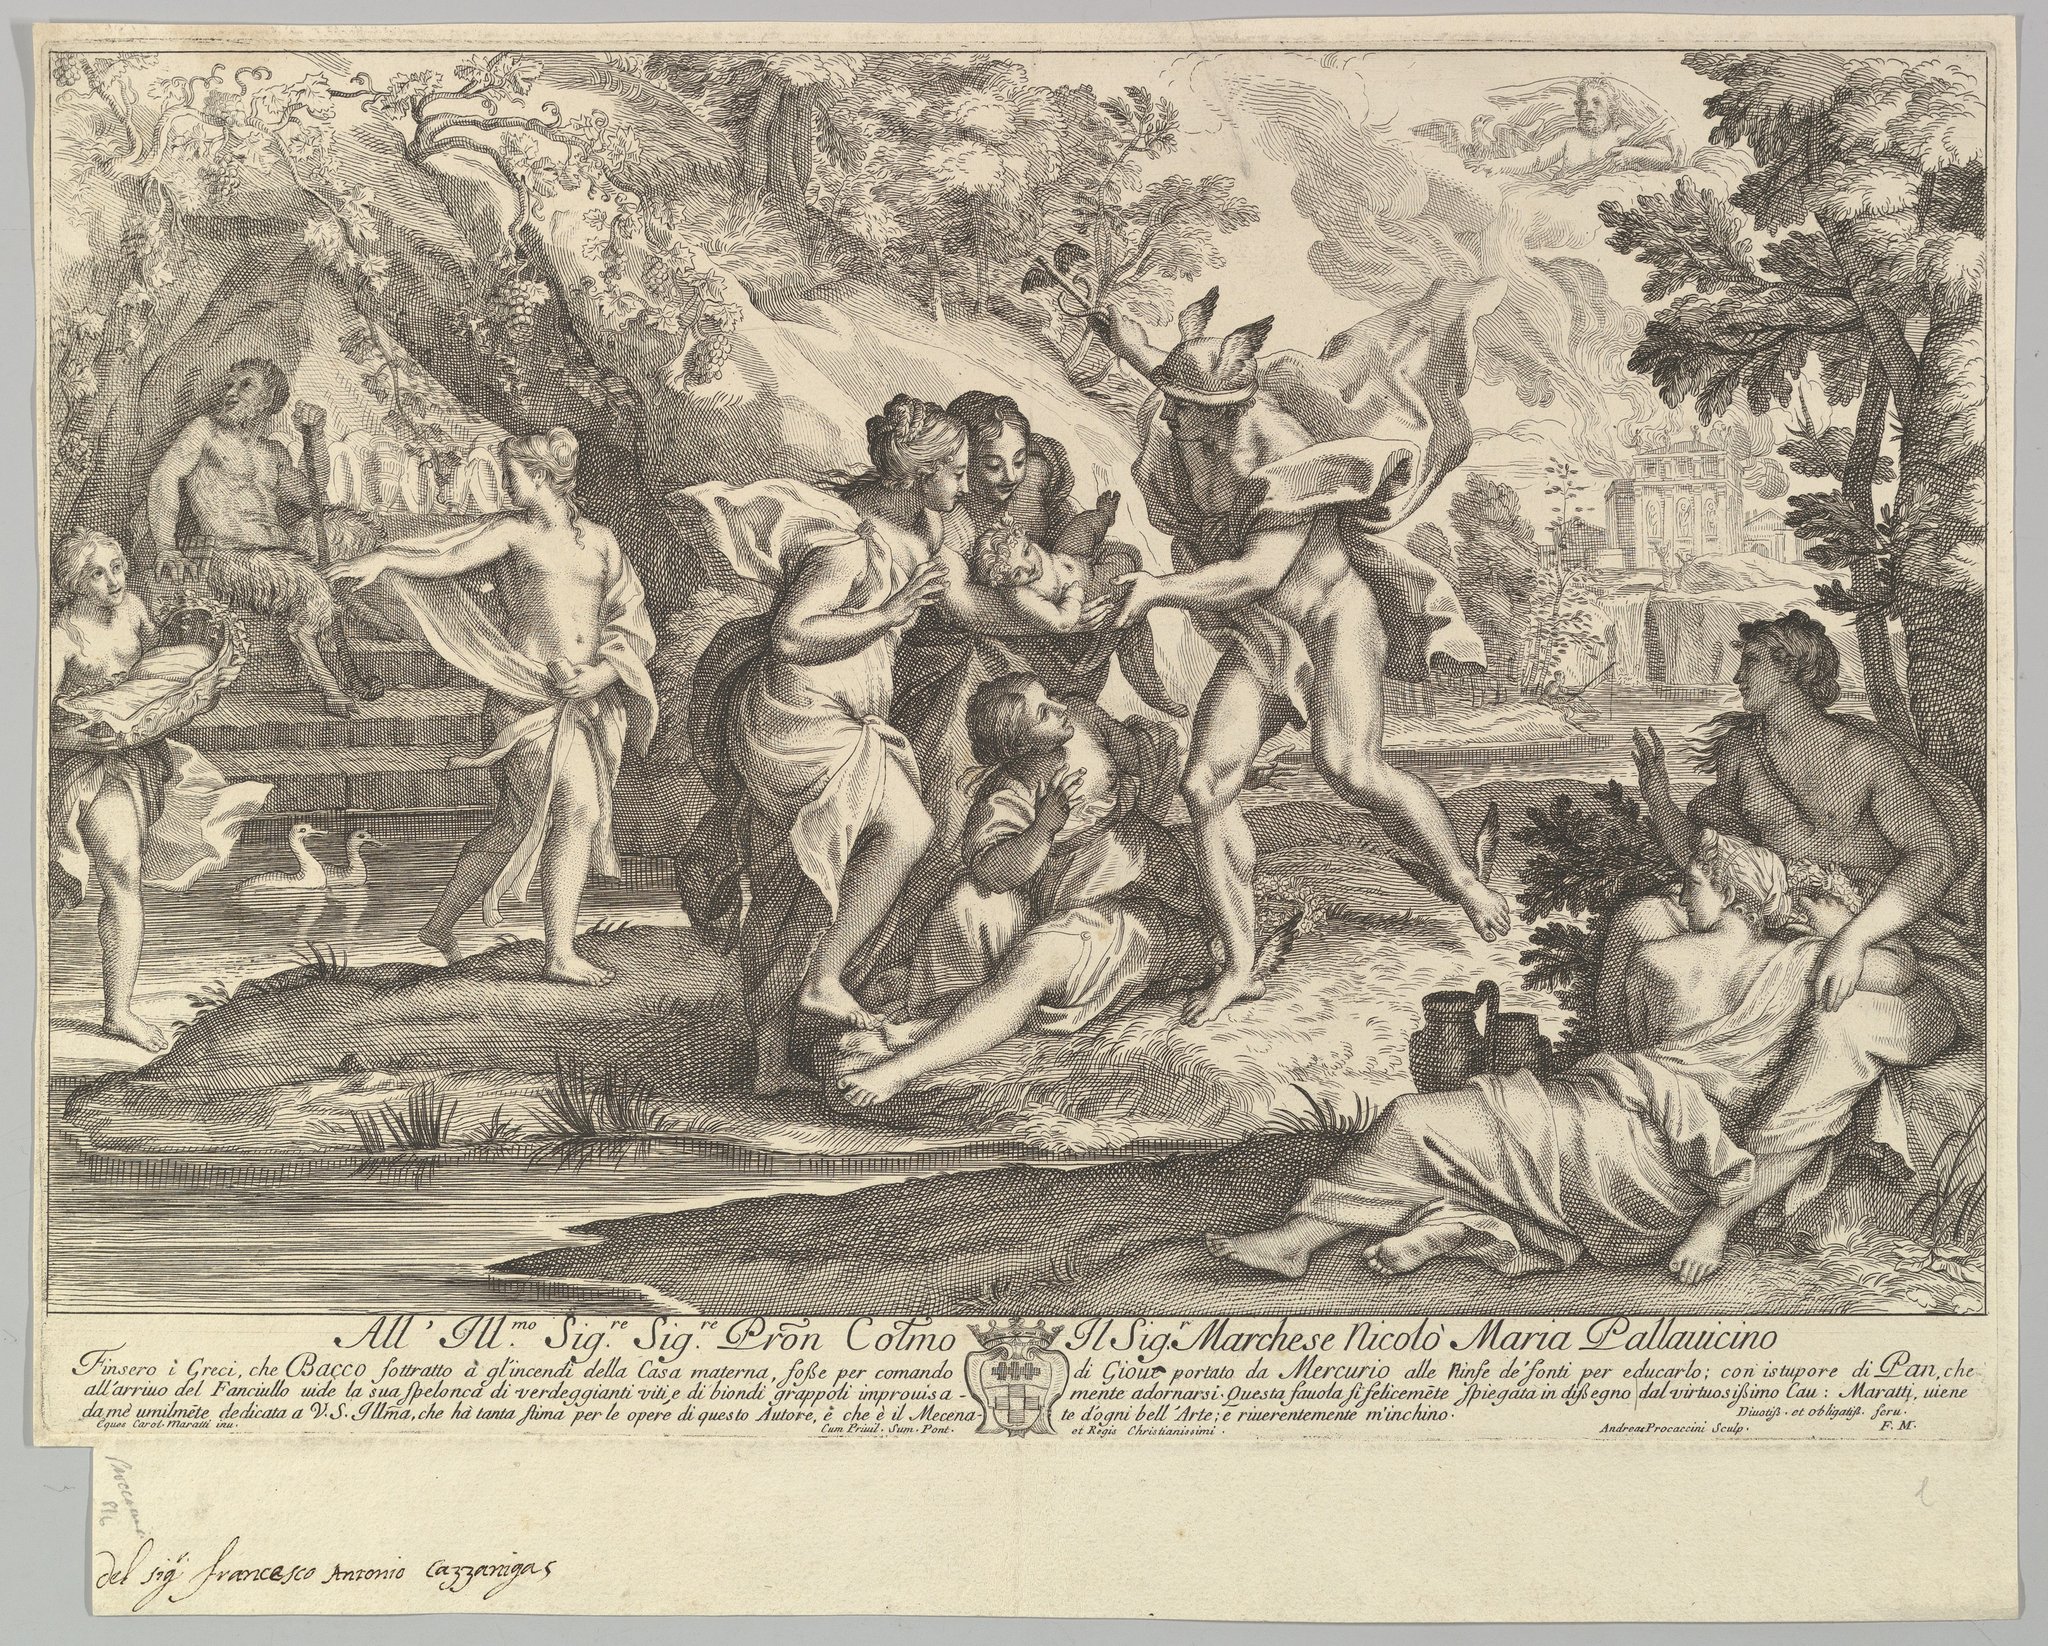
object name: print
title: Bacchus as a child given by Mercury to the care of the Nymphs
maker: andrea procaccini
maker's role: artist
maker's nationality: italian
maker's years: 1671-1734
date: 1671-1734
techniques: engraving, etching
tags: nymphs,bacchus,mercury,satyrs